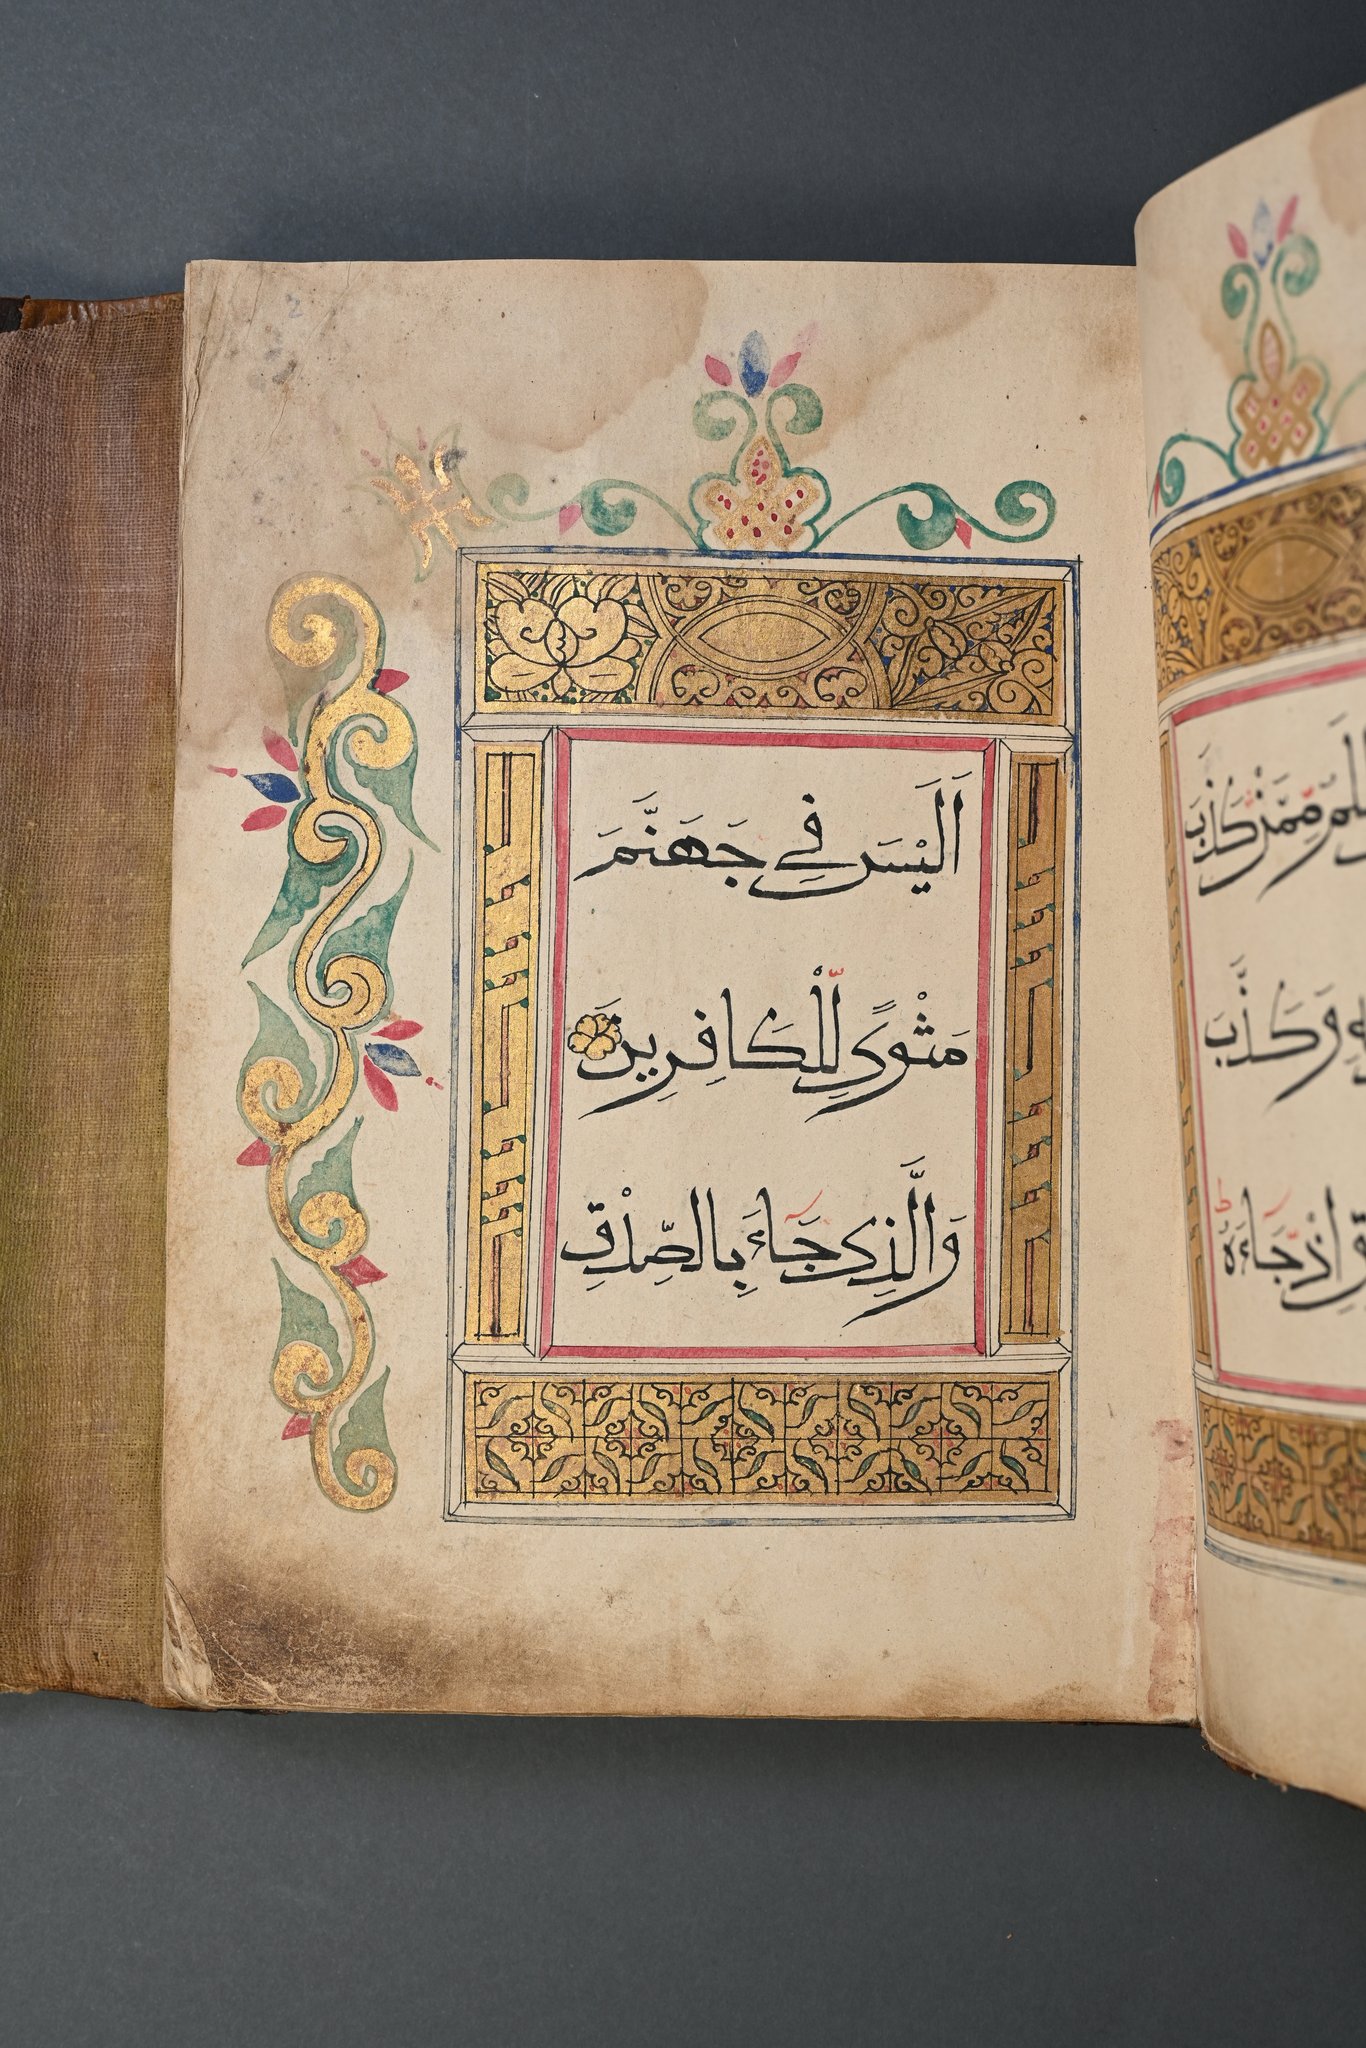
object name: non illustrated manuscript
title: Qur'an Juz' XXVI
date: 1601-1800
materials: gold, ink, leather, paper, watercolor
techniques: bookbinding, polychrome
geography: china